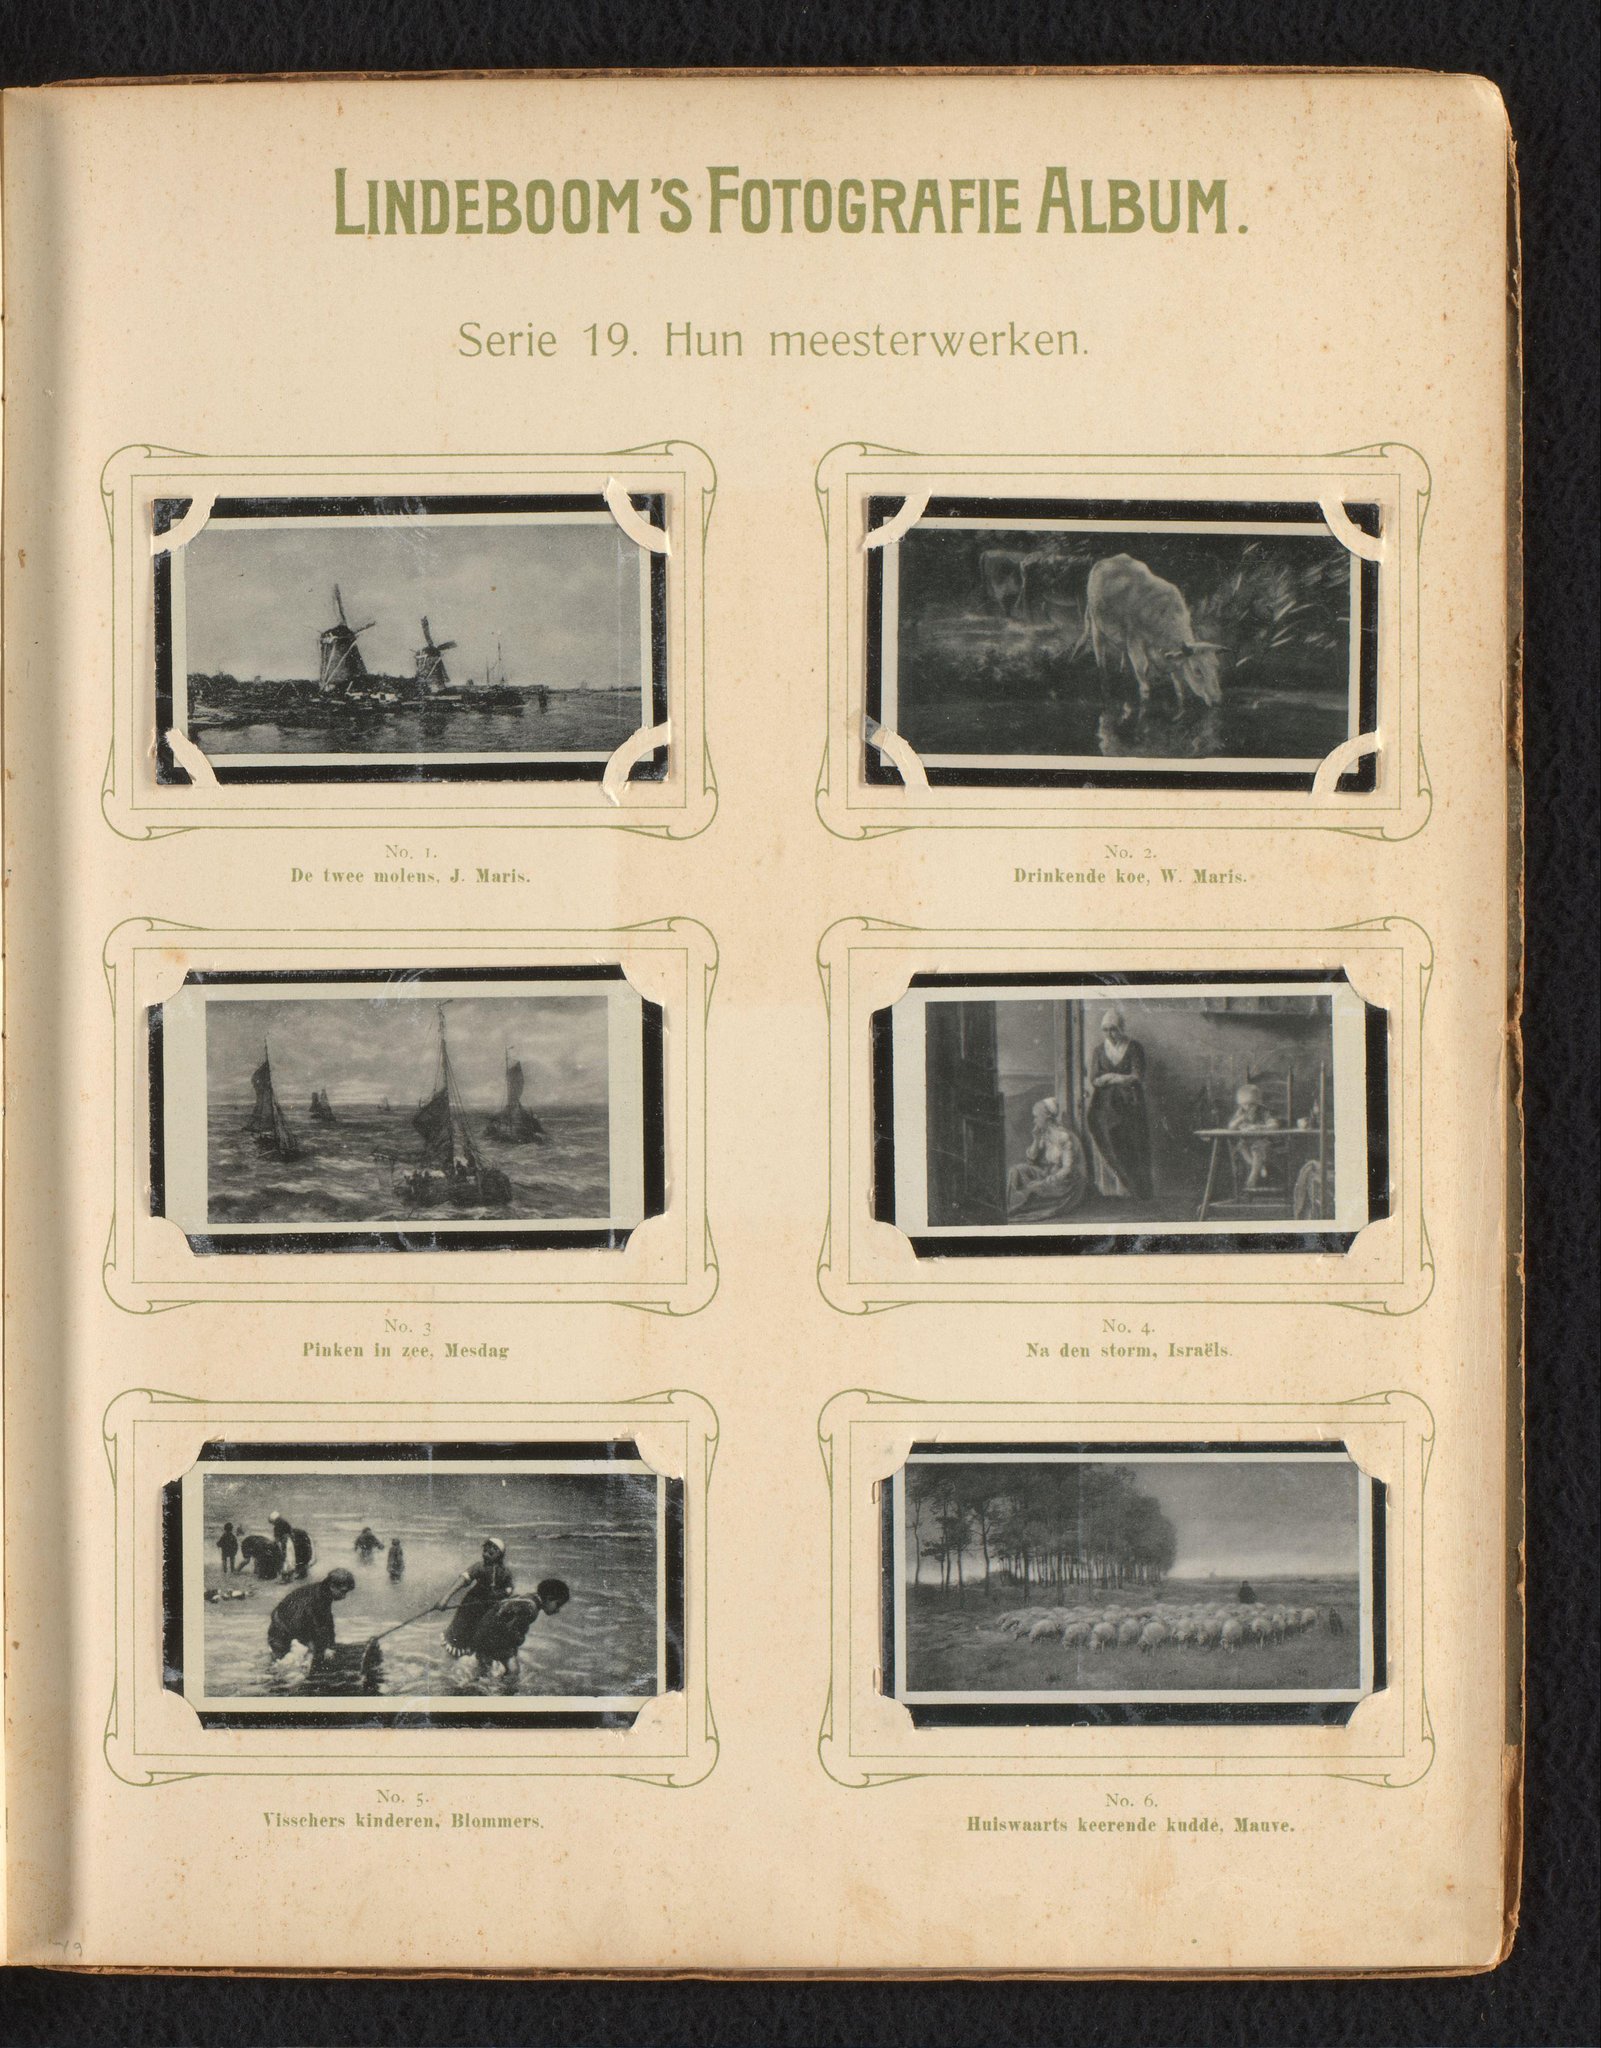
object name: reproduction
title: Zes reproducties van schilderijen van Jacob Maris, Willem Maris, Hendrik Willem Mesdag, Jozef Israëls, Bernard Blommers en Anton Mauve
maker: Anonymous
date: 1905-1906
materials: cardboard, paper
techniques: photograph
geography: amsterdam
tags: picture, painting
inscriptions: inscription: ‘Serie 19.’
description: Dergelijke prenten stonden bekend als 'zwartjes'. Men verkreeg ze bij aanschaf van bepaalde merken thee, cacao, sigaretten, beschuit, etc. om te verzamelen. Er waren speciaal voor de 'zwartjes' vervaardigde verzamelalbums in omloop.